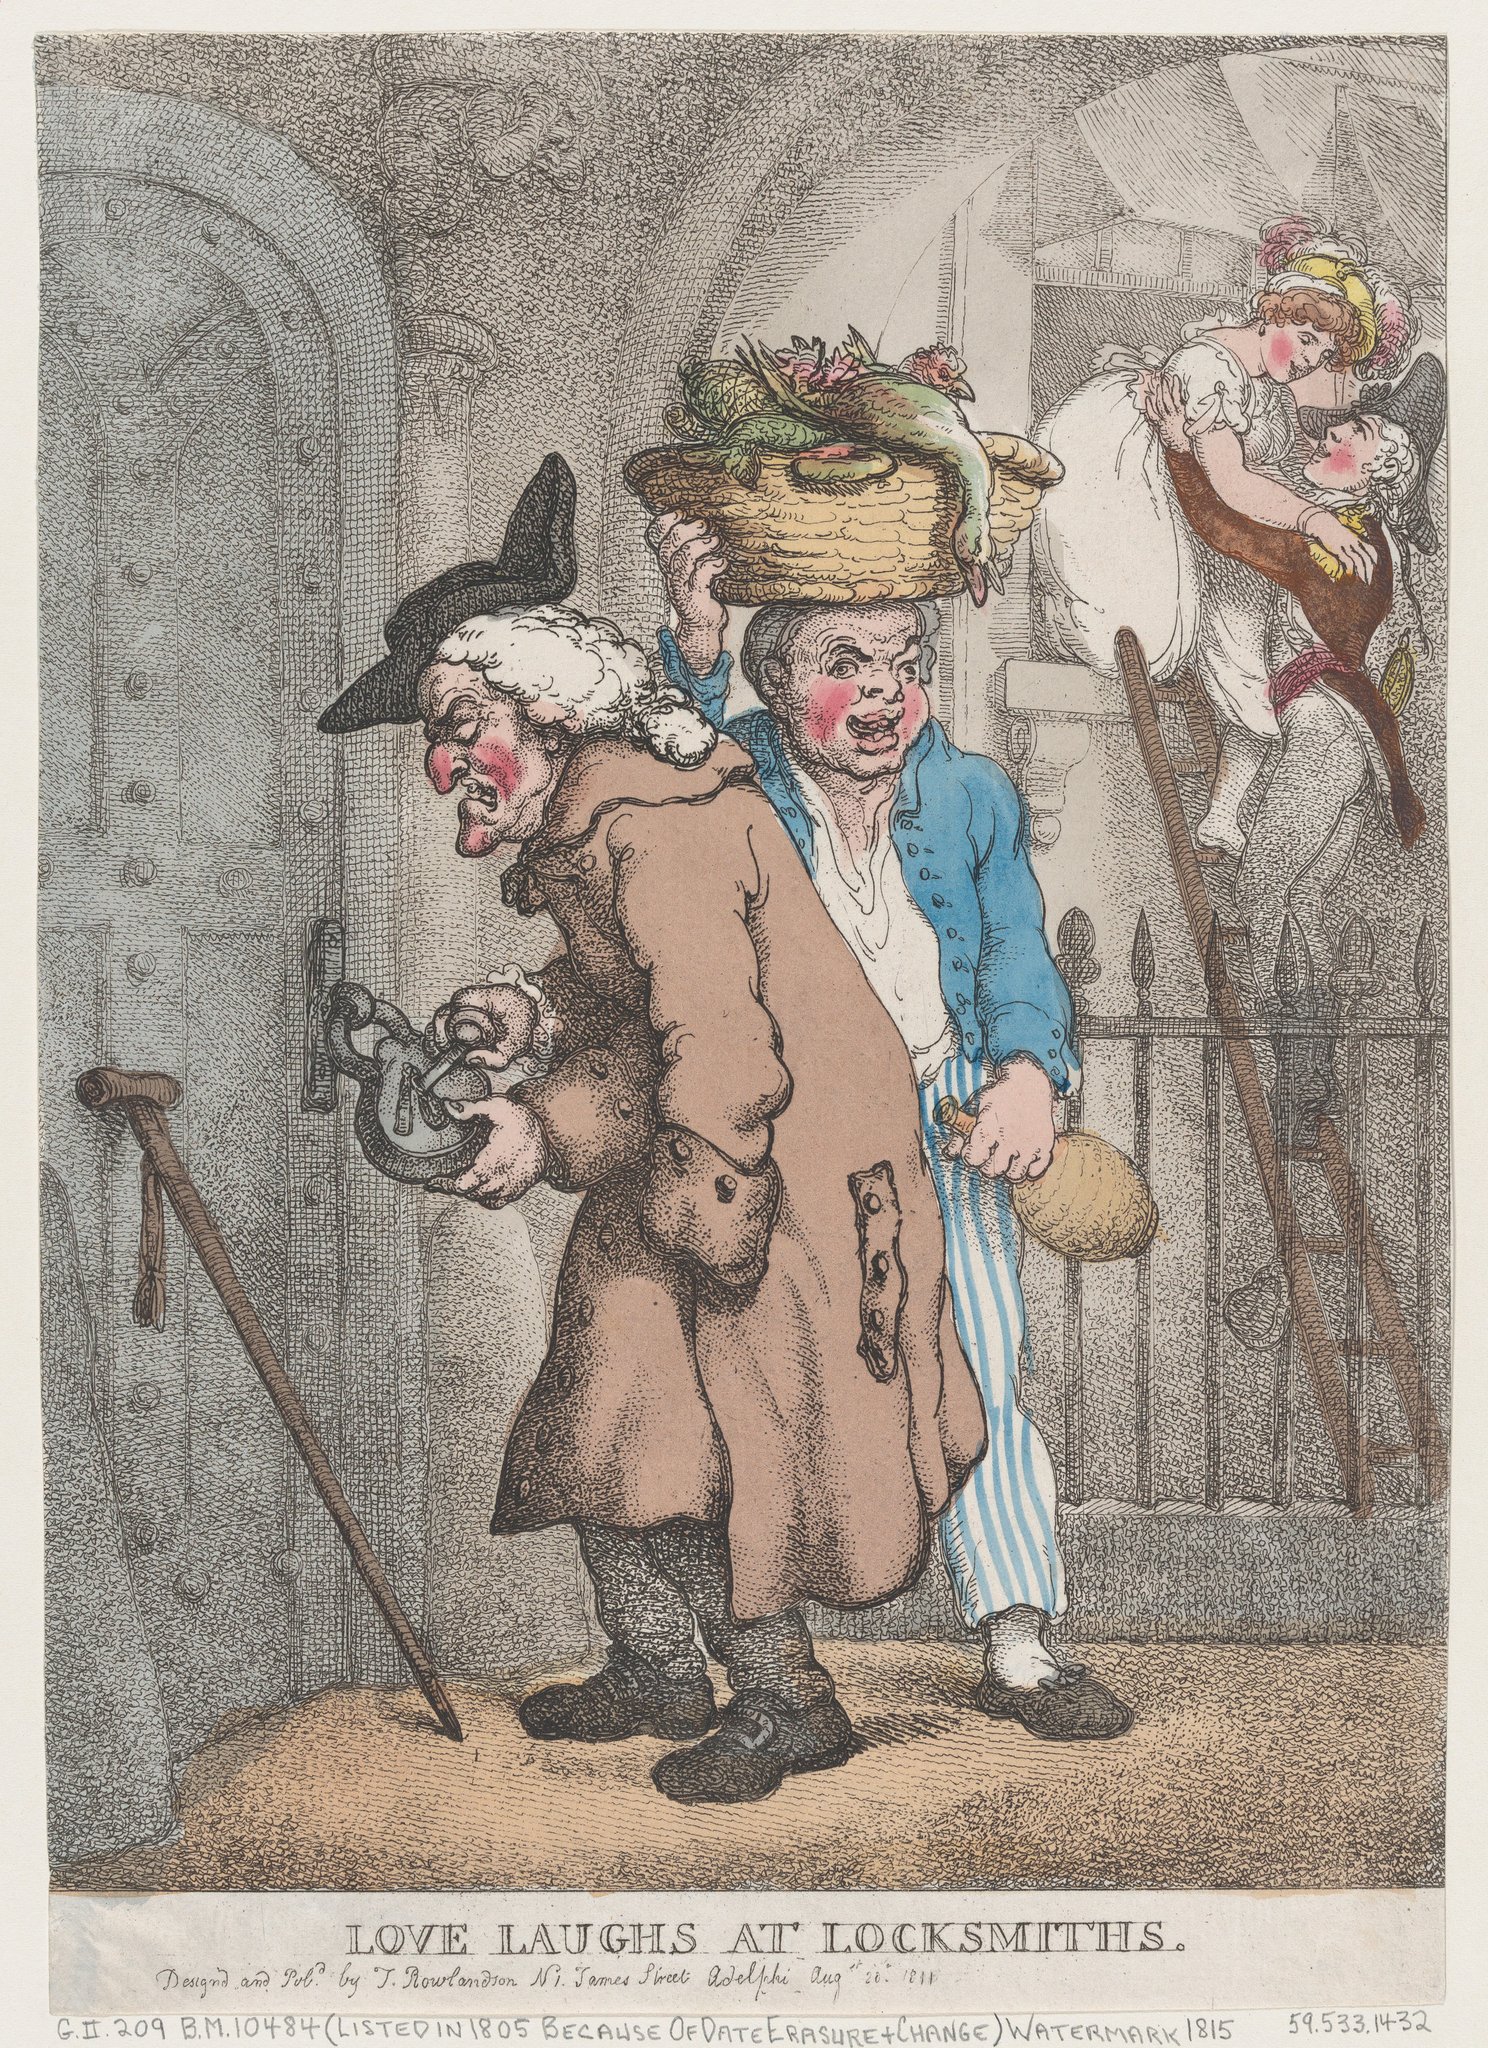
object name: print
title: Love Laughs at Locksmiths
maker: thomas rowlandson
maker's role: artist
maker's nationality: british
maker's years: 1757-1827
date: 1805-1811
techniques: etching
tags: satire,couples,men,women